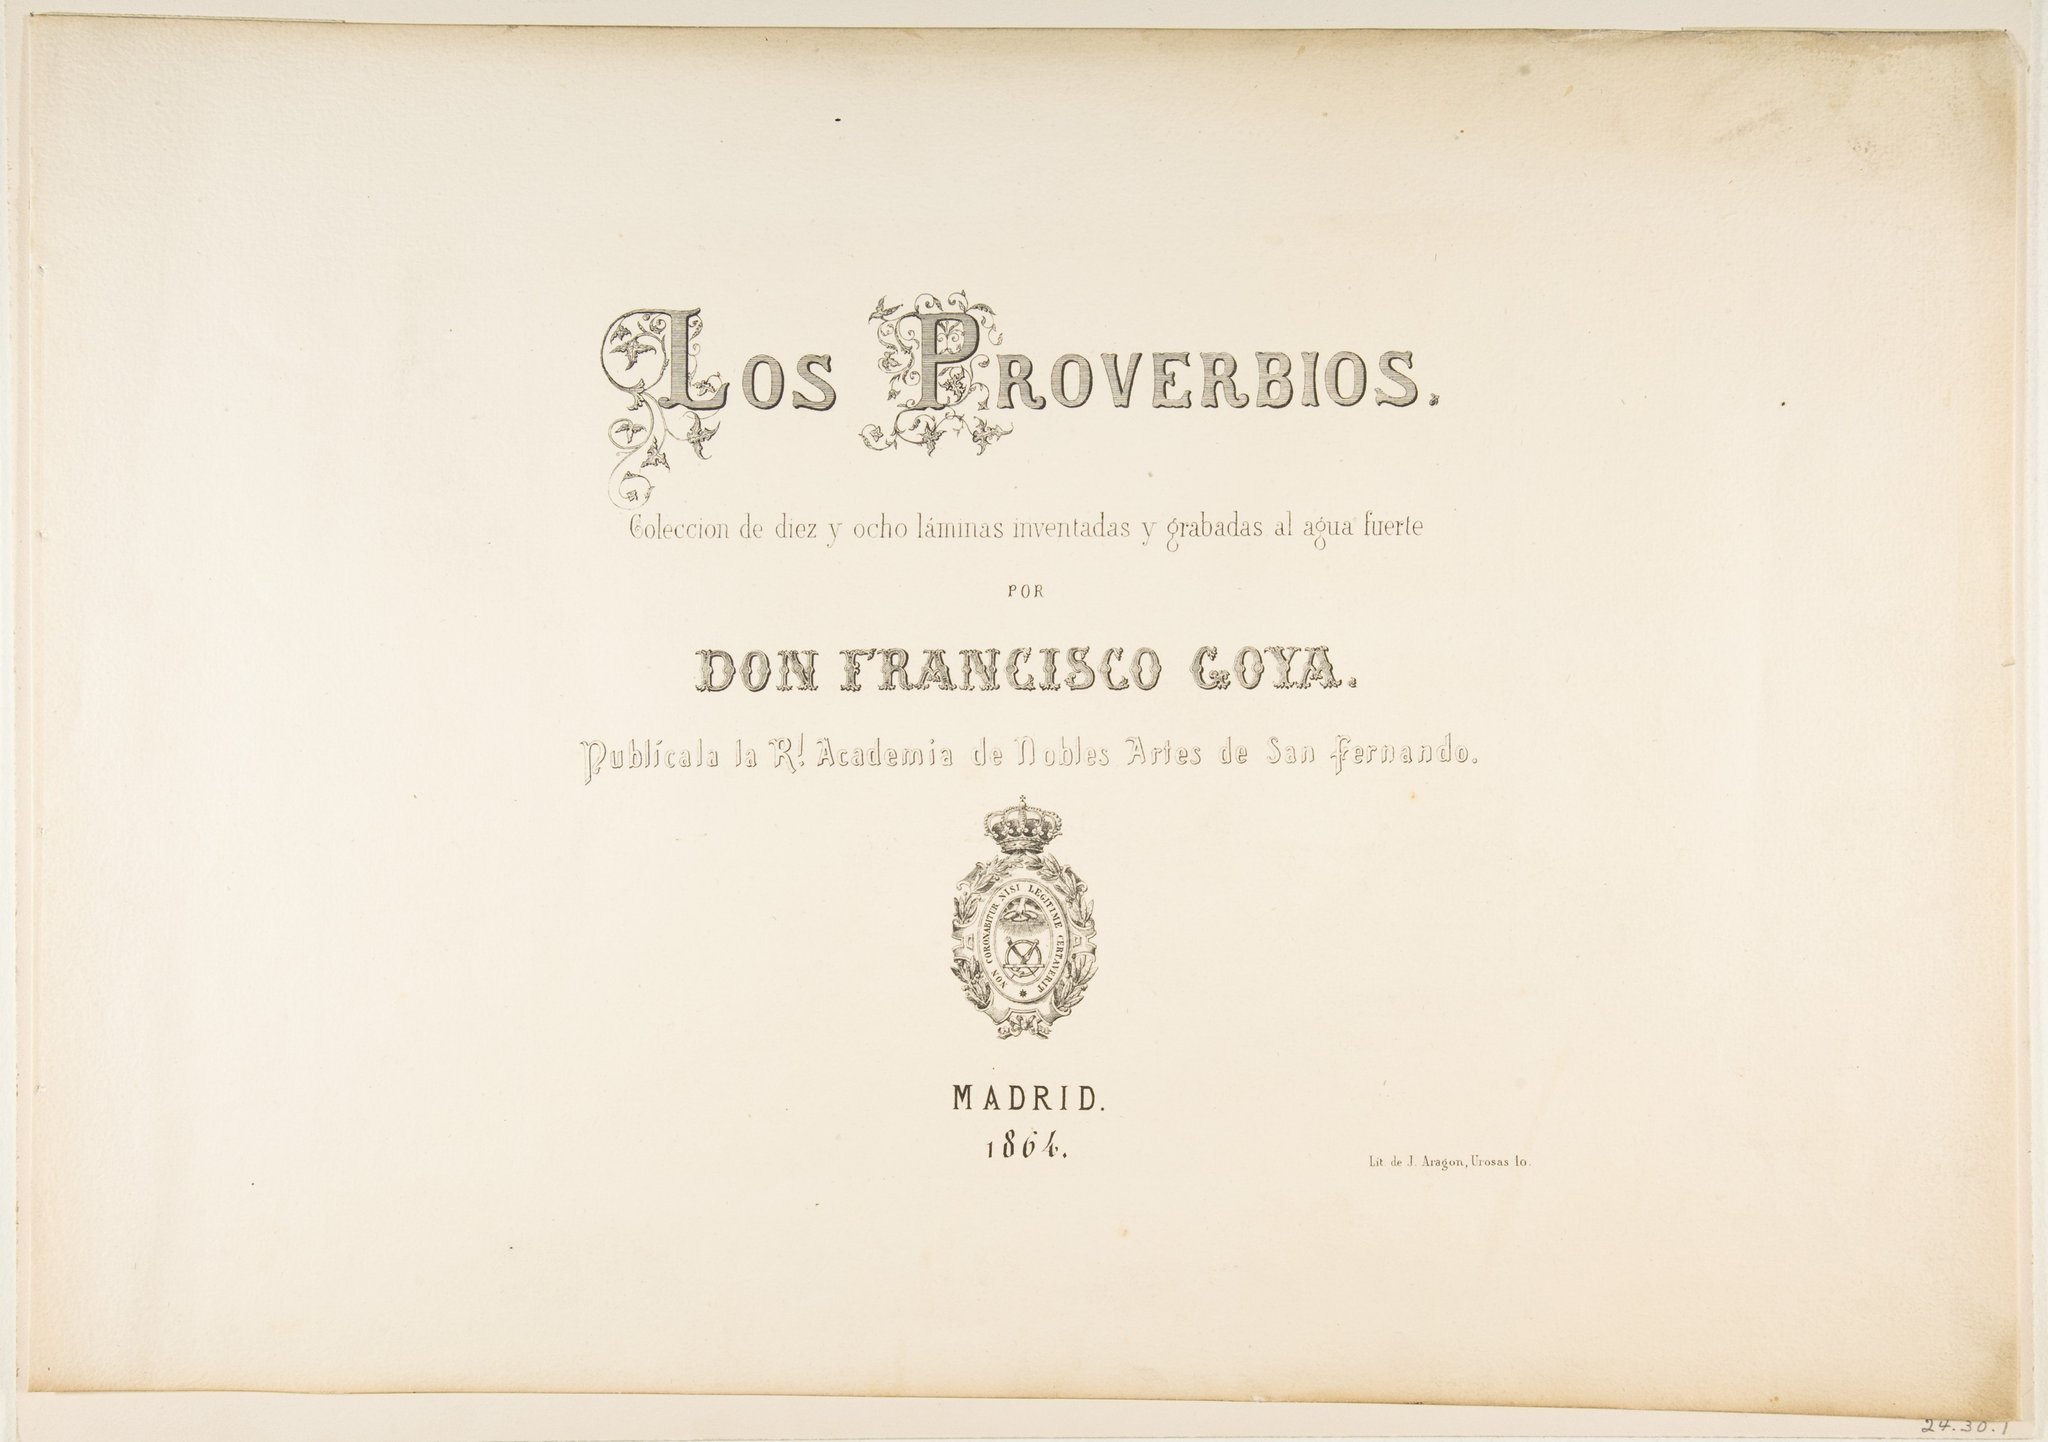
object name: print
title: Title page for "Los Proverbios" (Disparates)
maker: goya (francisco de goya y lucientes)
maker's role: artist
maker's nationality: spanish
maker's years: 1746-1828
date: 1864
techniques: lithograph